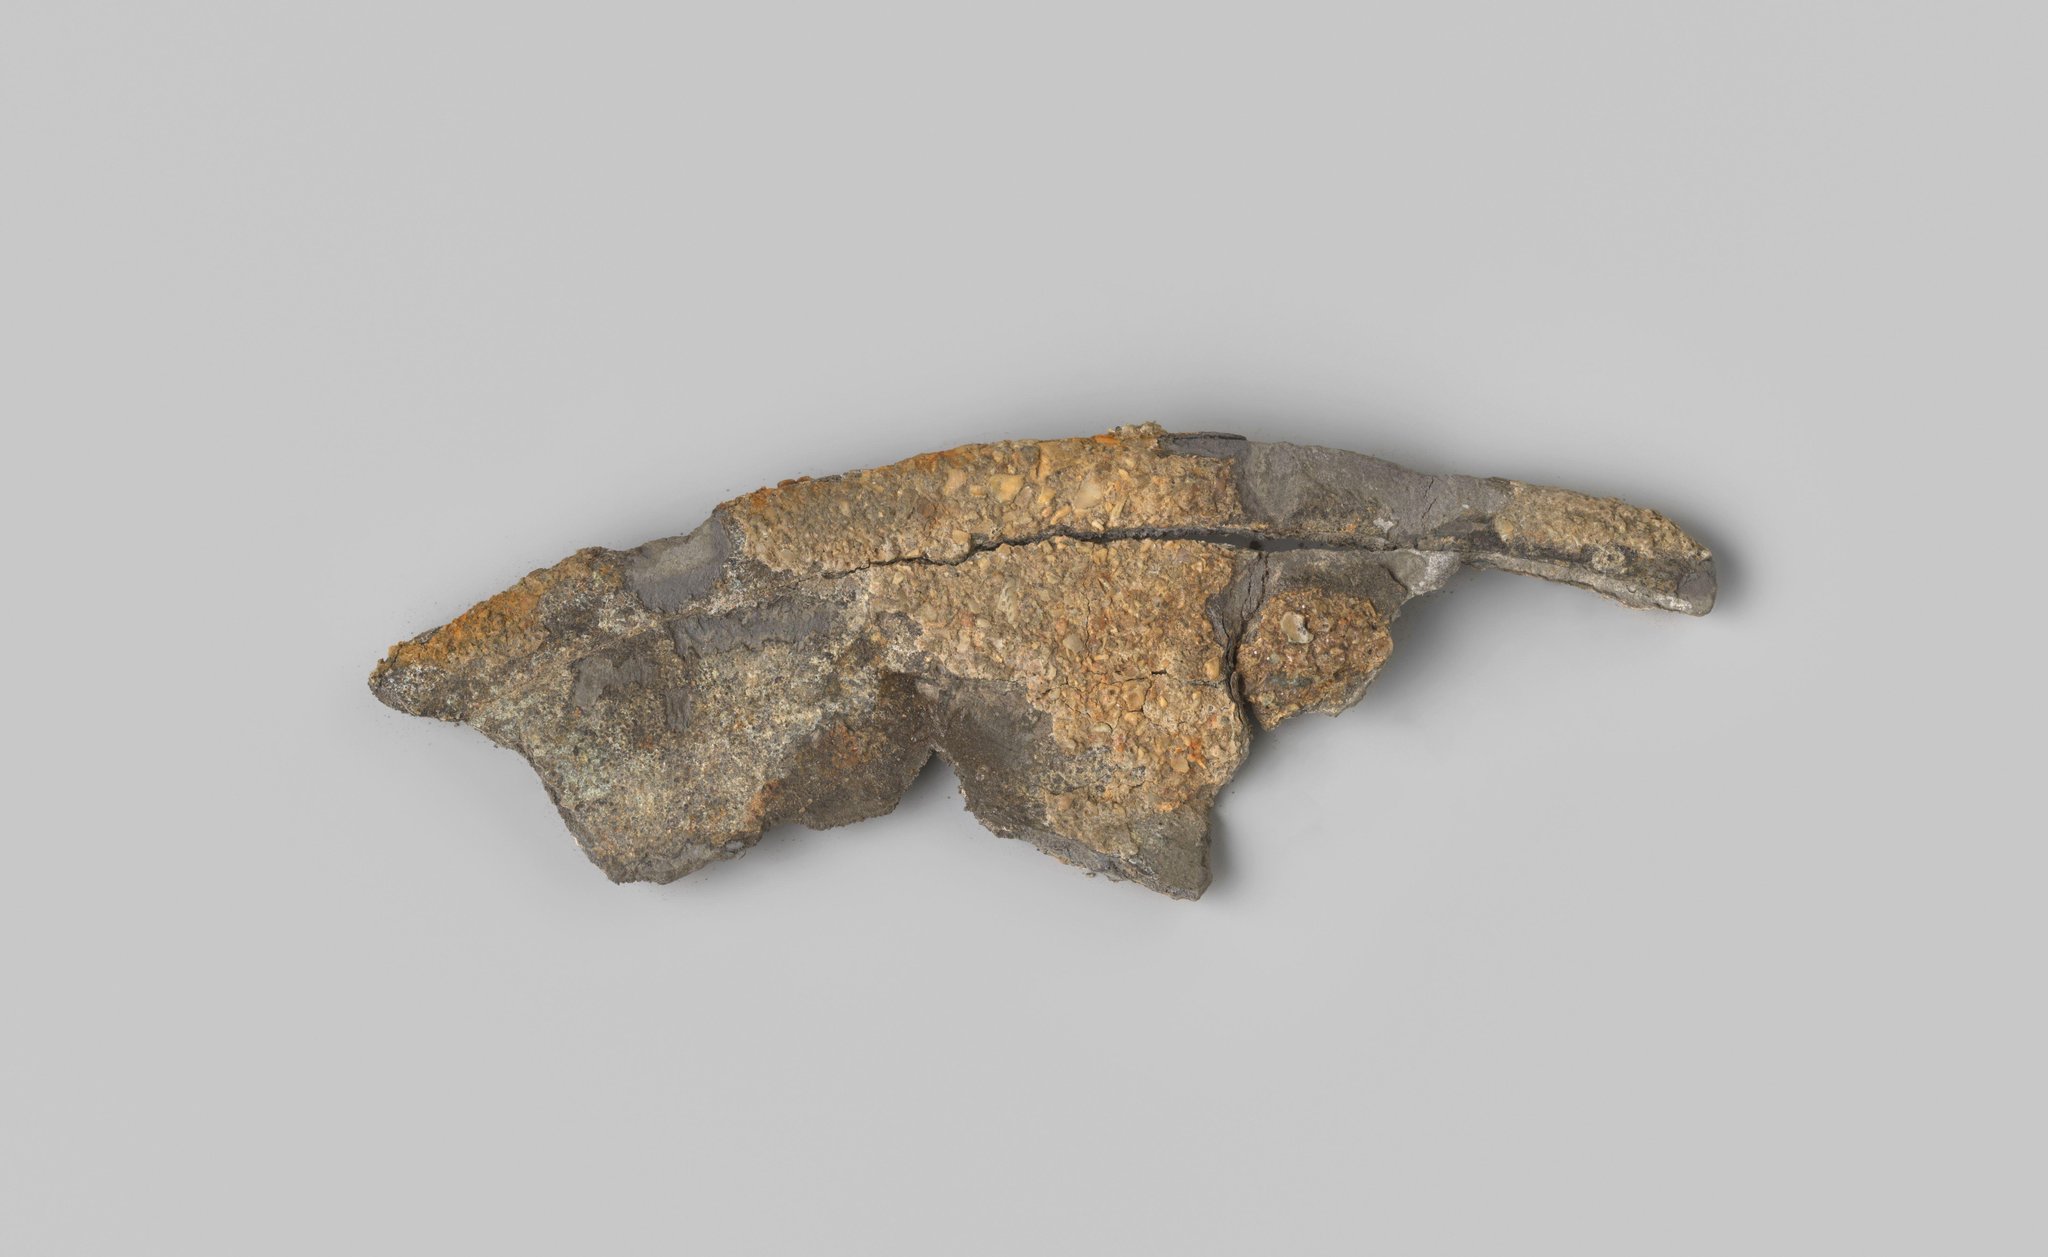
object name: plate dish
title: Fragment rand van een bord uit het wrak van de Oost-Indiëvaarder Hollandia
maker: Anonymous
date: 1700-1743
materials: tin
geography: netherlands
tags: verenigde oostindische compagnie, hollandia (schip), annet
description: Plate, fragm of rim, id. NG 1980-27H2288, corroded.